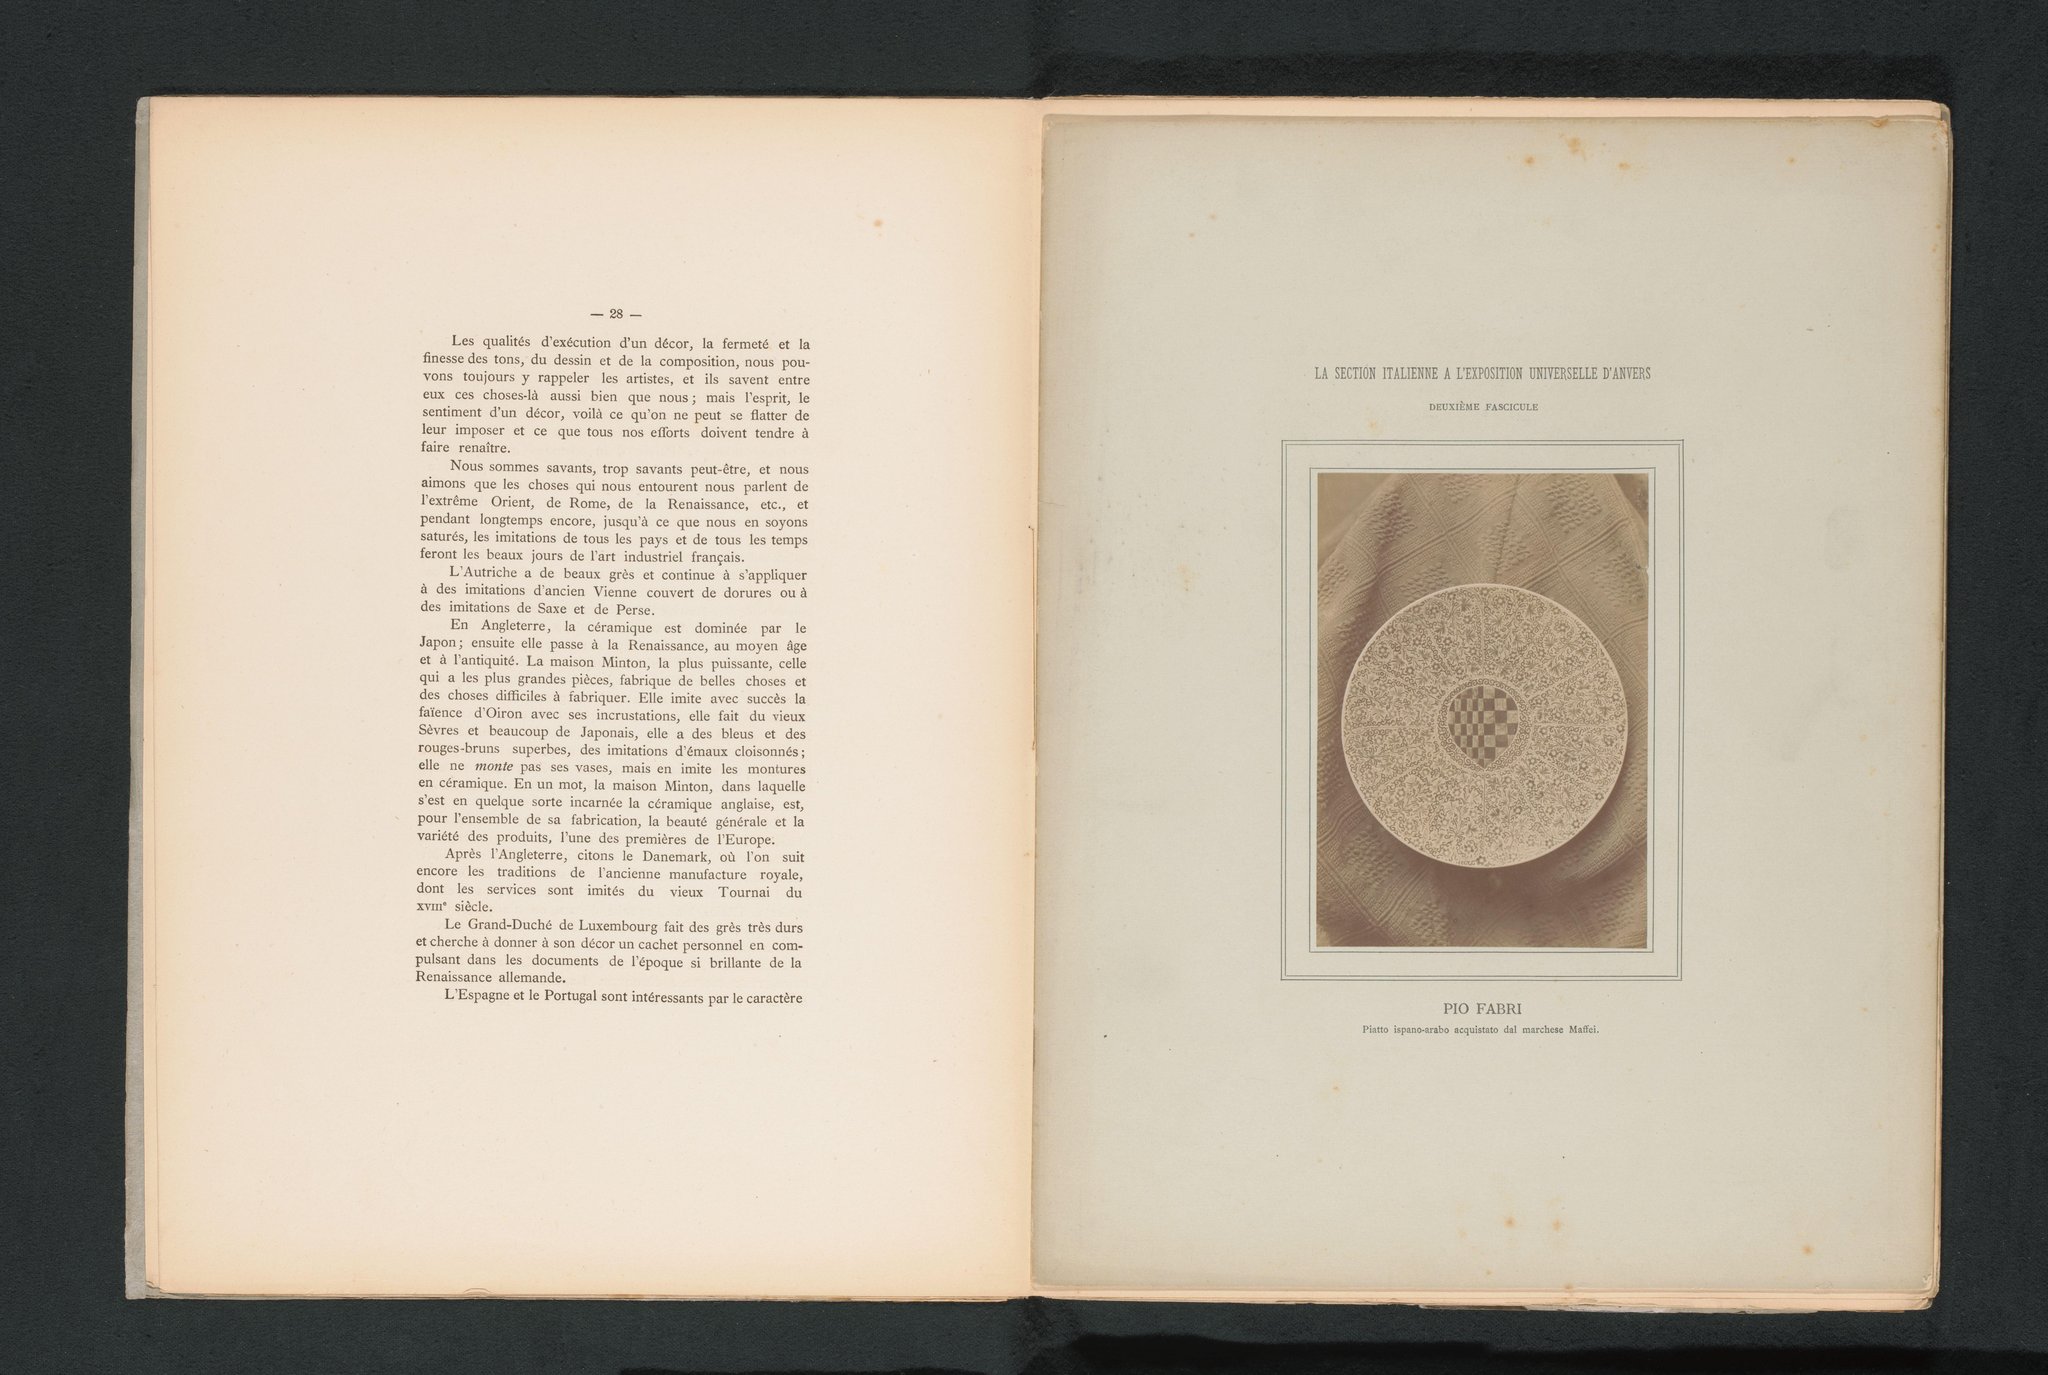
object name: photograph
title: Gedecoreerd servies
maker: Anonymous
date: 1880-1885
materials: photographic support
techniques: albumen print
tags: table-ware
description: Foto op losse plaat tegenover pagina 28.